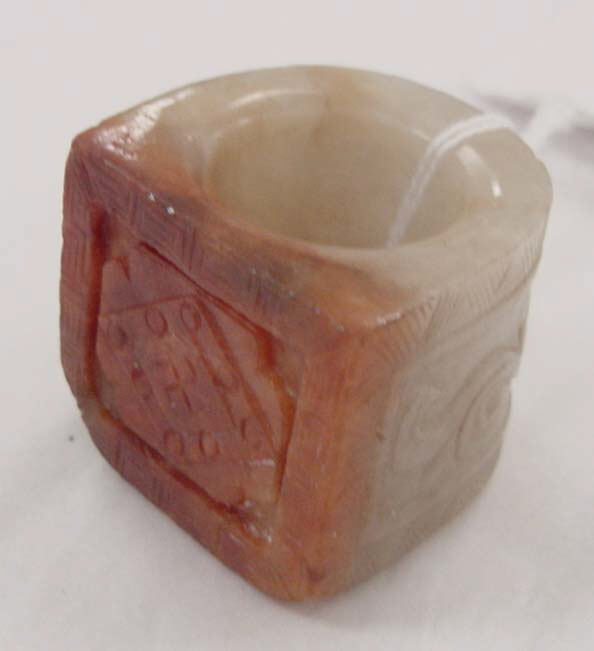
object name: ring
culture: chinese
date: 1801-1900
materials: jade